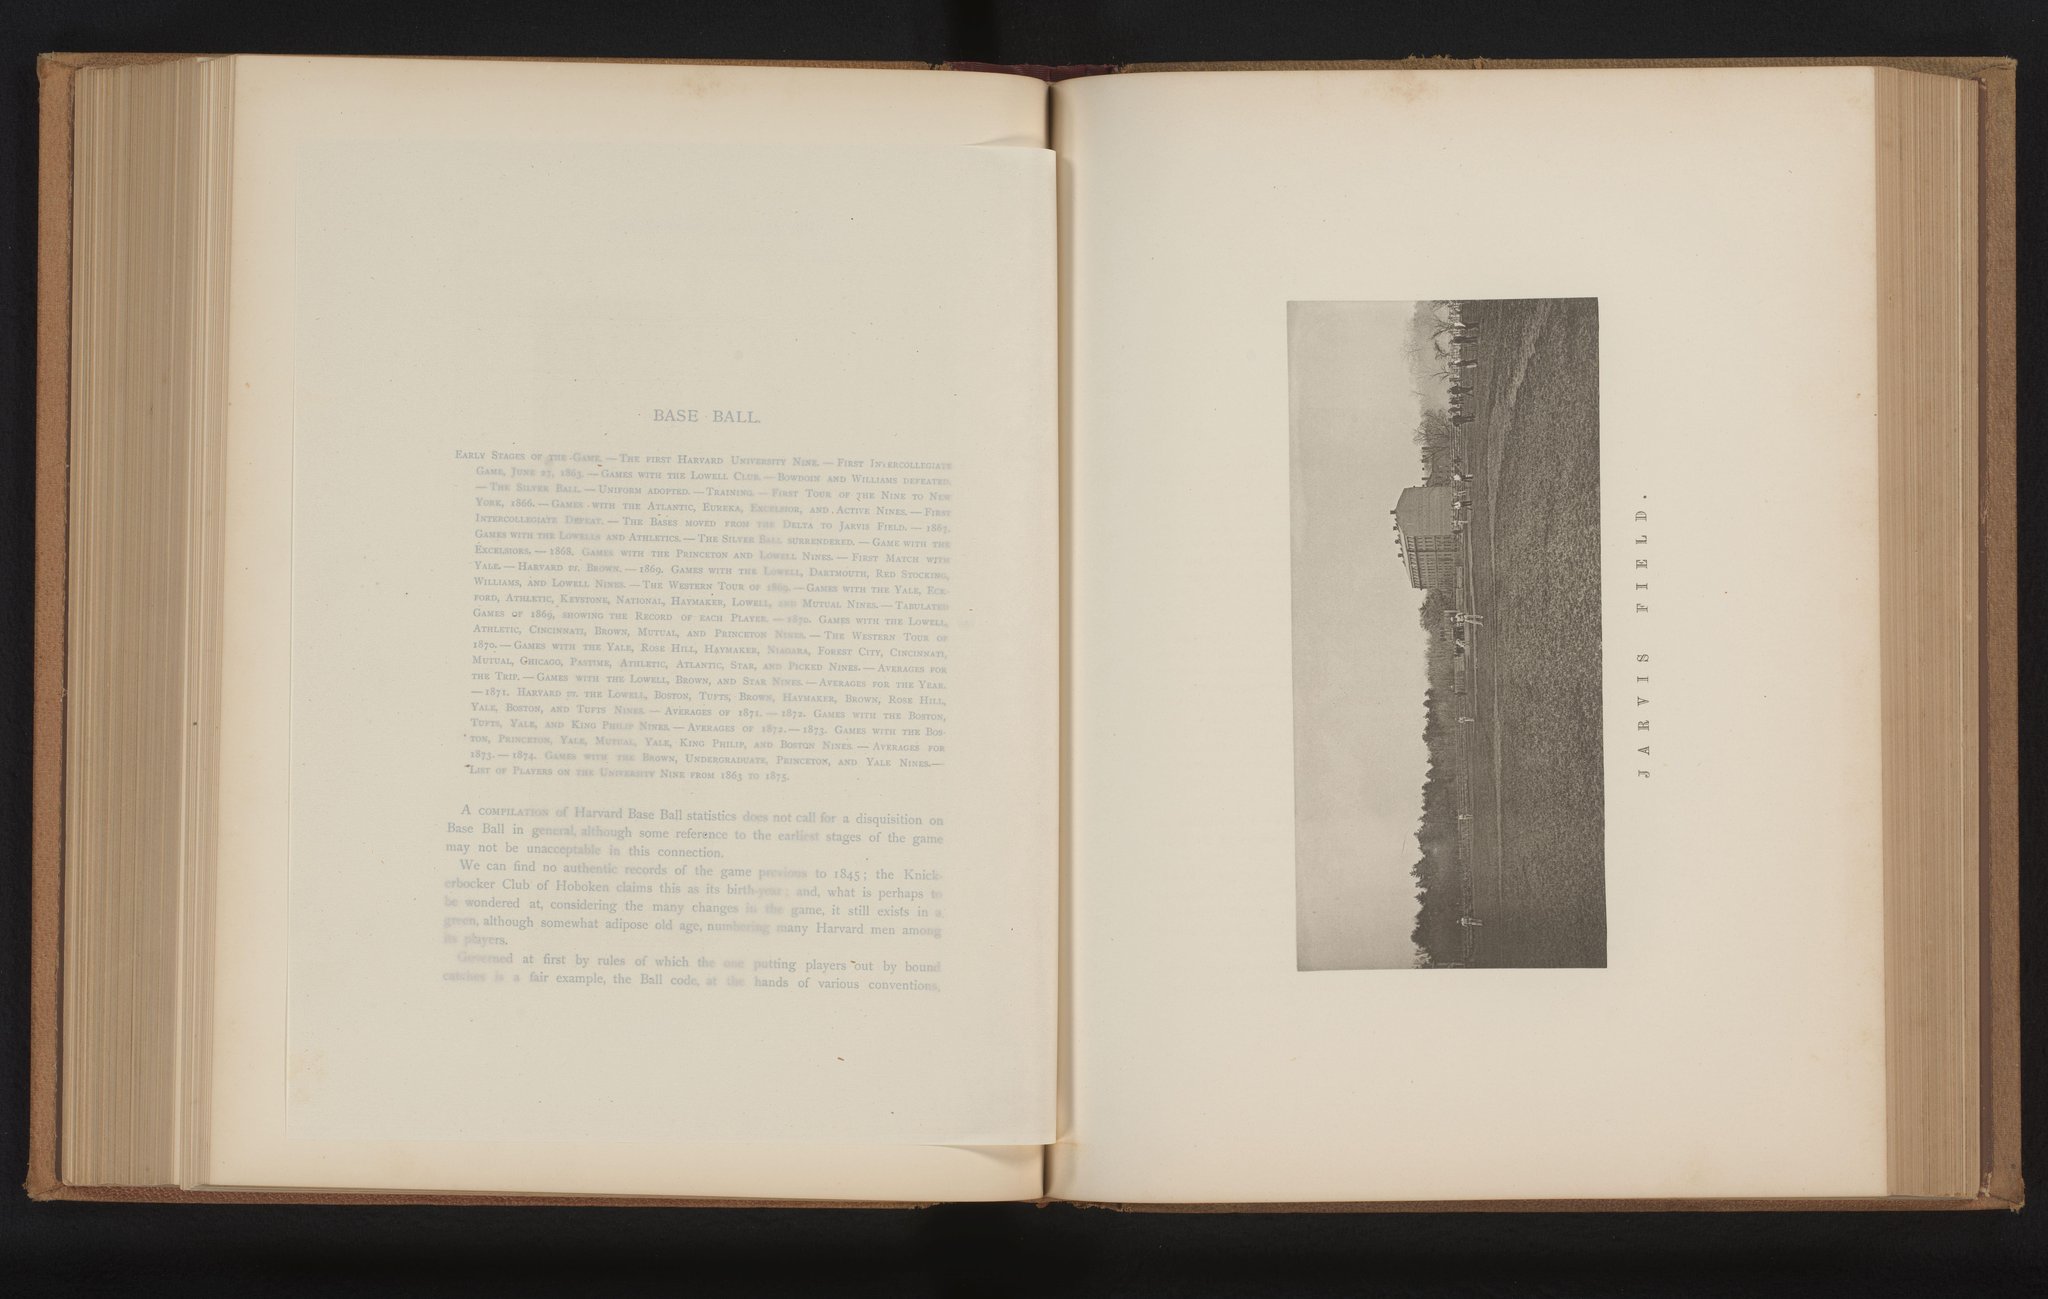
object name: page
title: Gezicht op Jarvis Field van de Harvard-universiteit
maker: Anonymous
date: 1870-1875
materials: paper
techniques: photograph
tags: baseball (+ sportsman, player, etc.), grounds, fields and accomodations for sports, games and physical performances (+ sportsman, player, etc.)